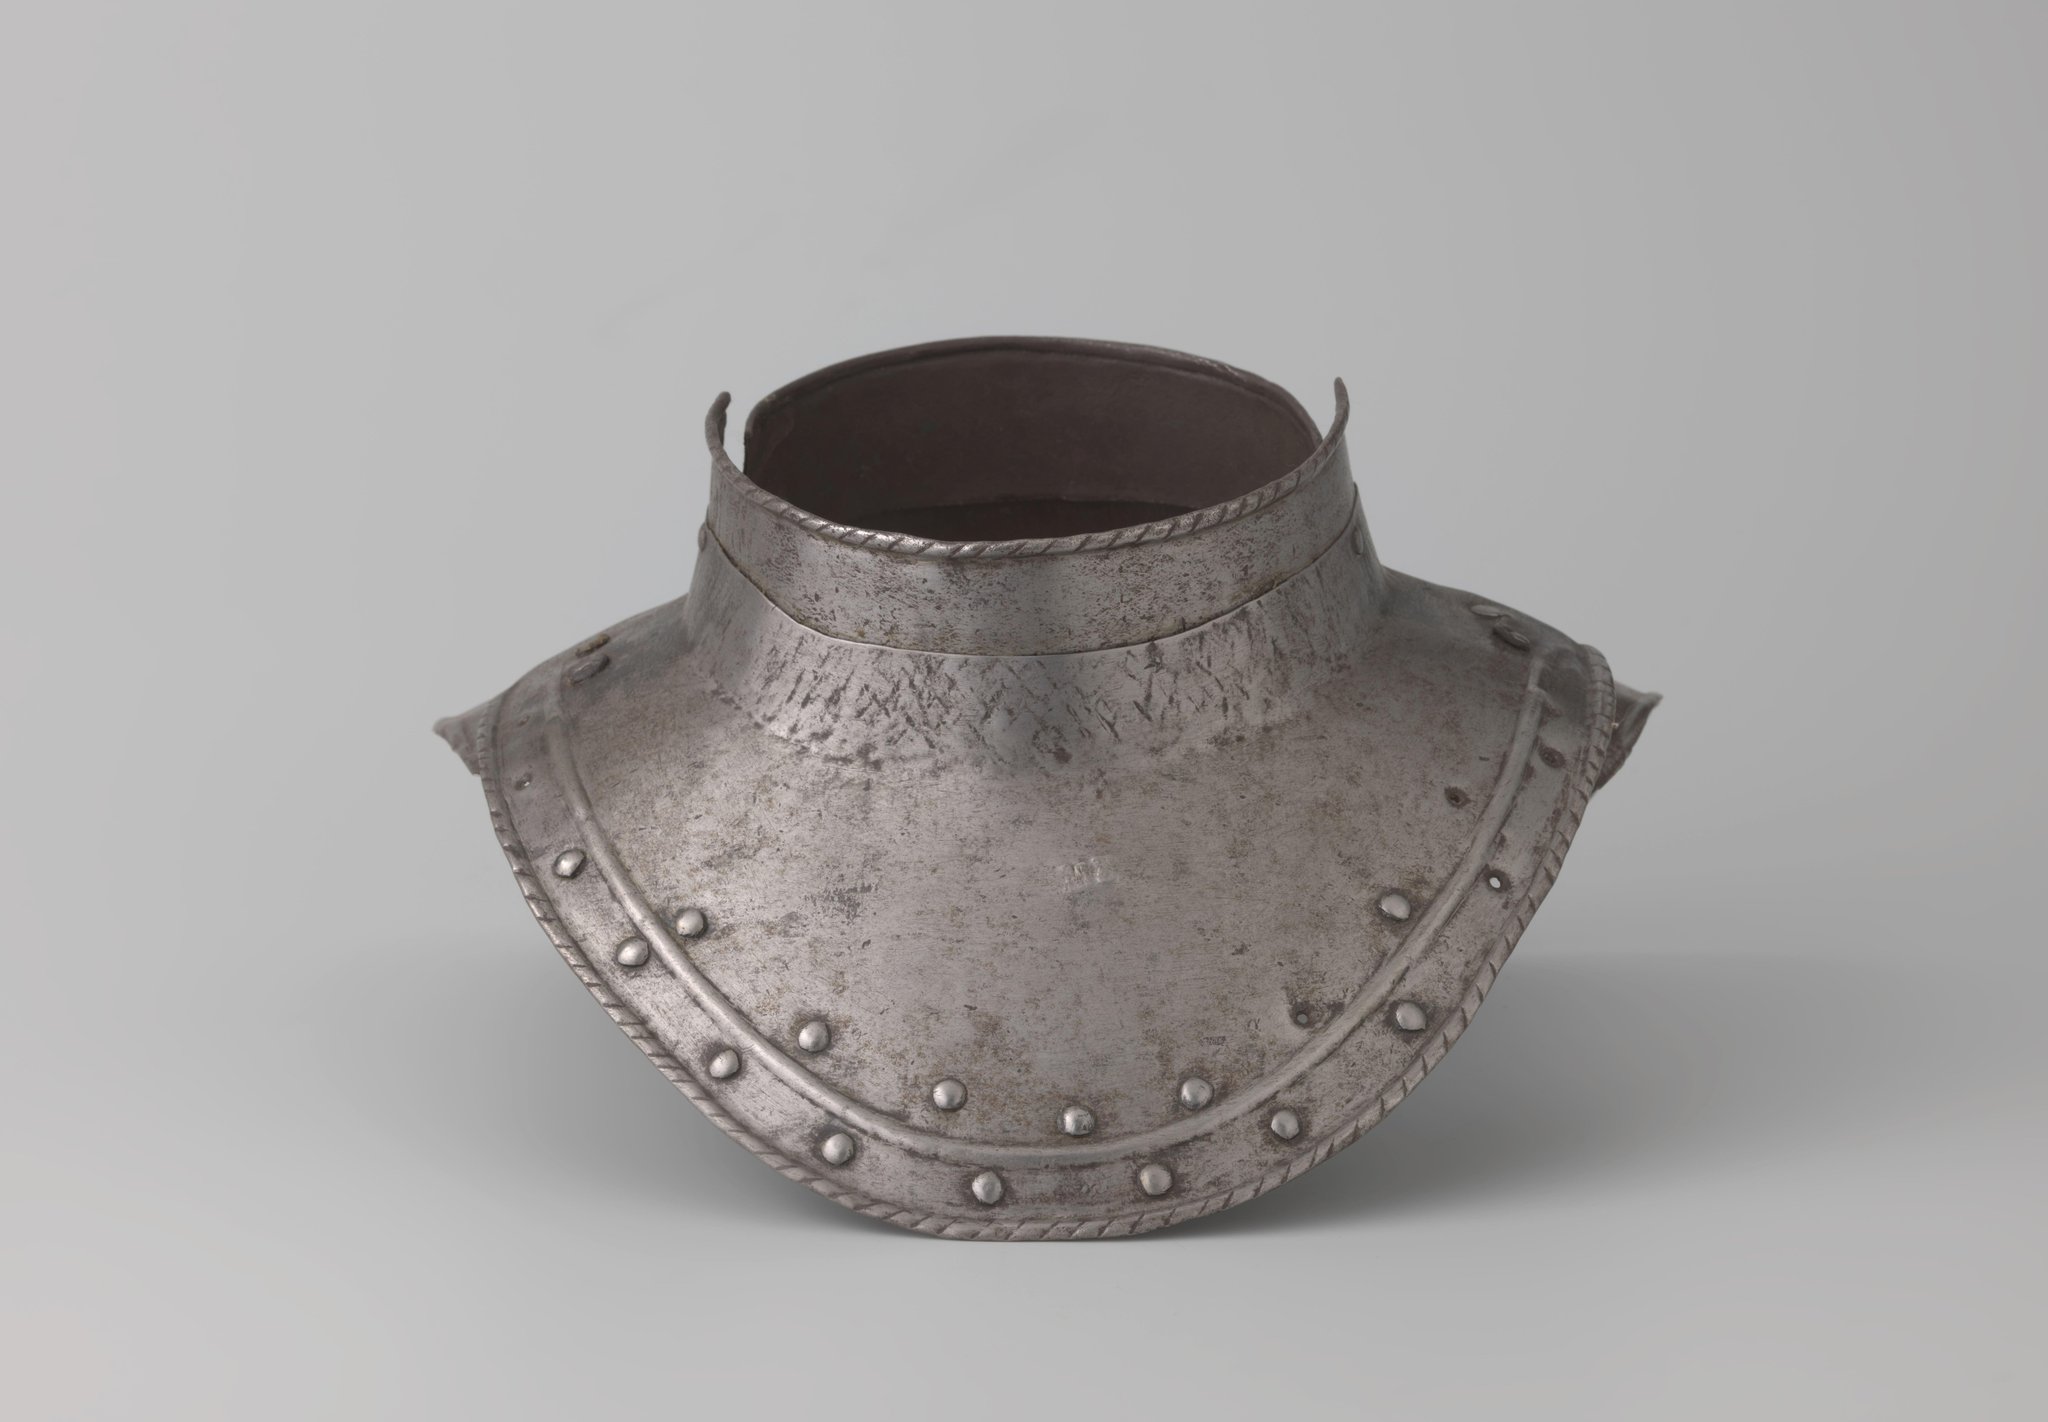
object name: gorget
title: Ringkraag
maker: Anonymous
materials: iron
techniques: forging, striking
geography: europe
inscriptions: : ‘S’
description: Ringkraag van ijzer, blank, uit vier delen gemaakt. De voorzijde is rondvormig maar loopt breed uit naar de zijkanten, een dubbele rij blanke klinknagels met een gebolde rand bevinden zich over de gehele breedte van de vo0rkant, de onderrand is gekabeld. De achterzijde is rechthoekiger maar loopt rond uit naar de zijkanten, de onderand is geflenst. De hoofdopening is rond met een gekabelde omgeflenste rand. De binnenzijde is zwart geverfd.